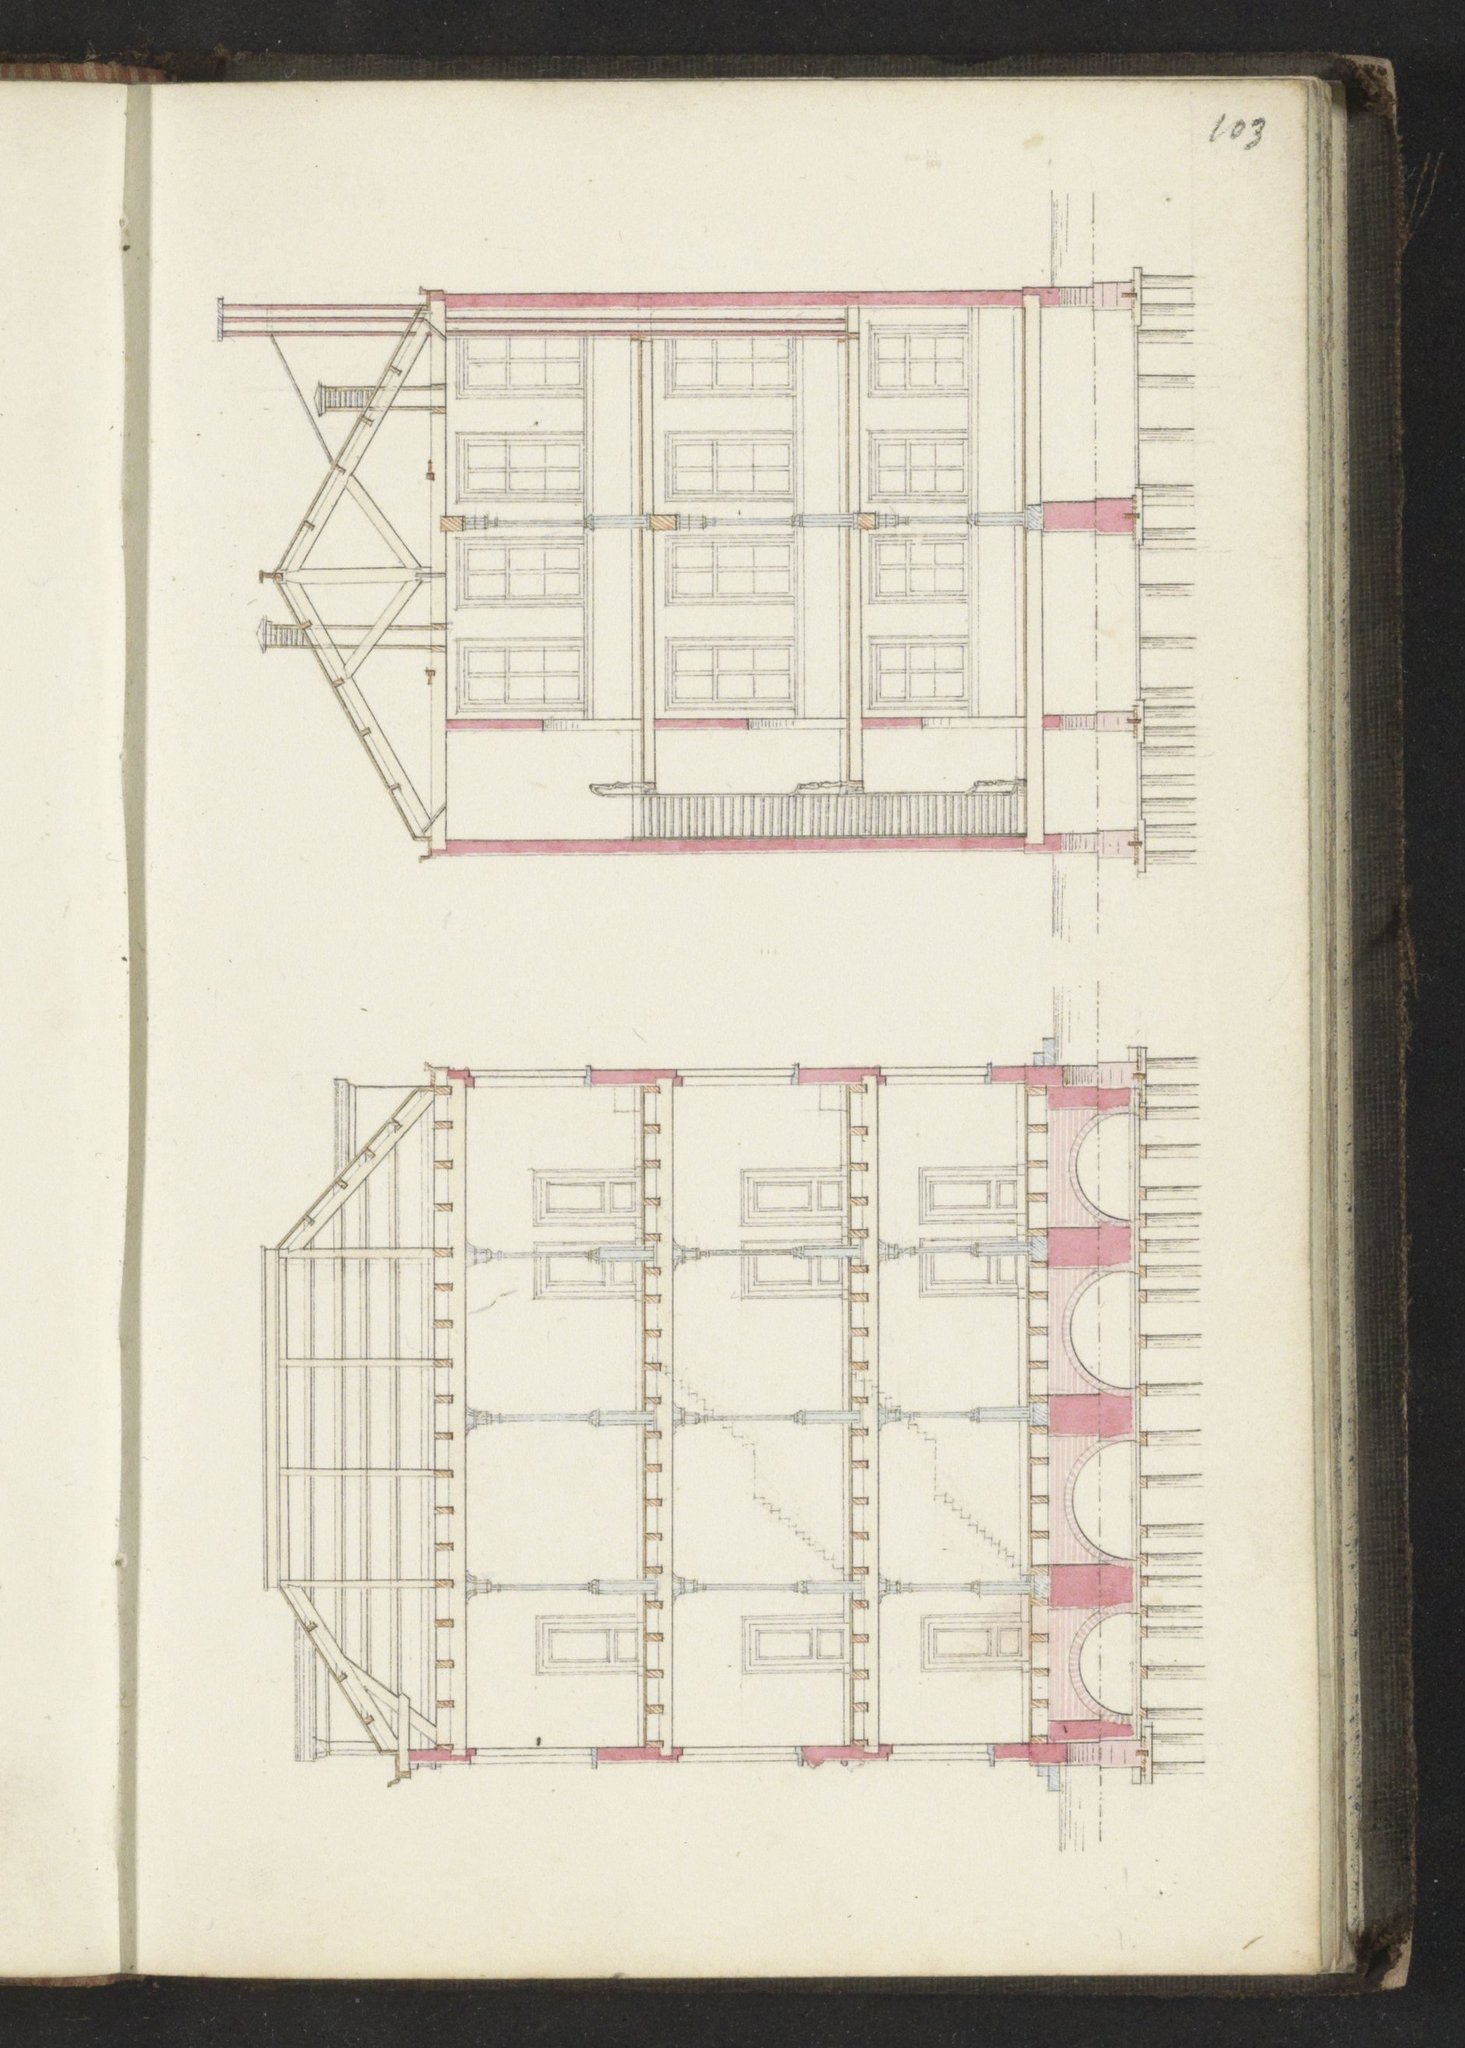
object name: sketchbook leaf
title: Doorsneden van een gebouw in de lengte en breedte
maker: willem springer jr.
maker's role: draughtsman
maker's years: 1815-1907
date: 1864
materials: ink, paper, pencil, watercolor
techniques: brush, pen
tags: section ~ architectural design or model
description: Pagina 103 uit een schetsboek met 164 pagina's.